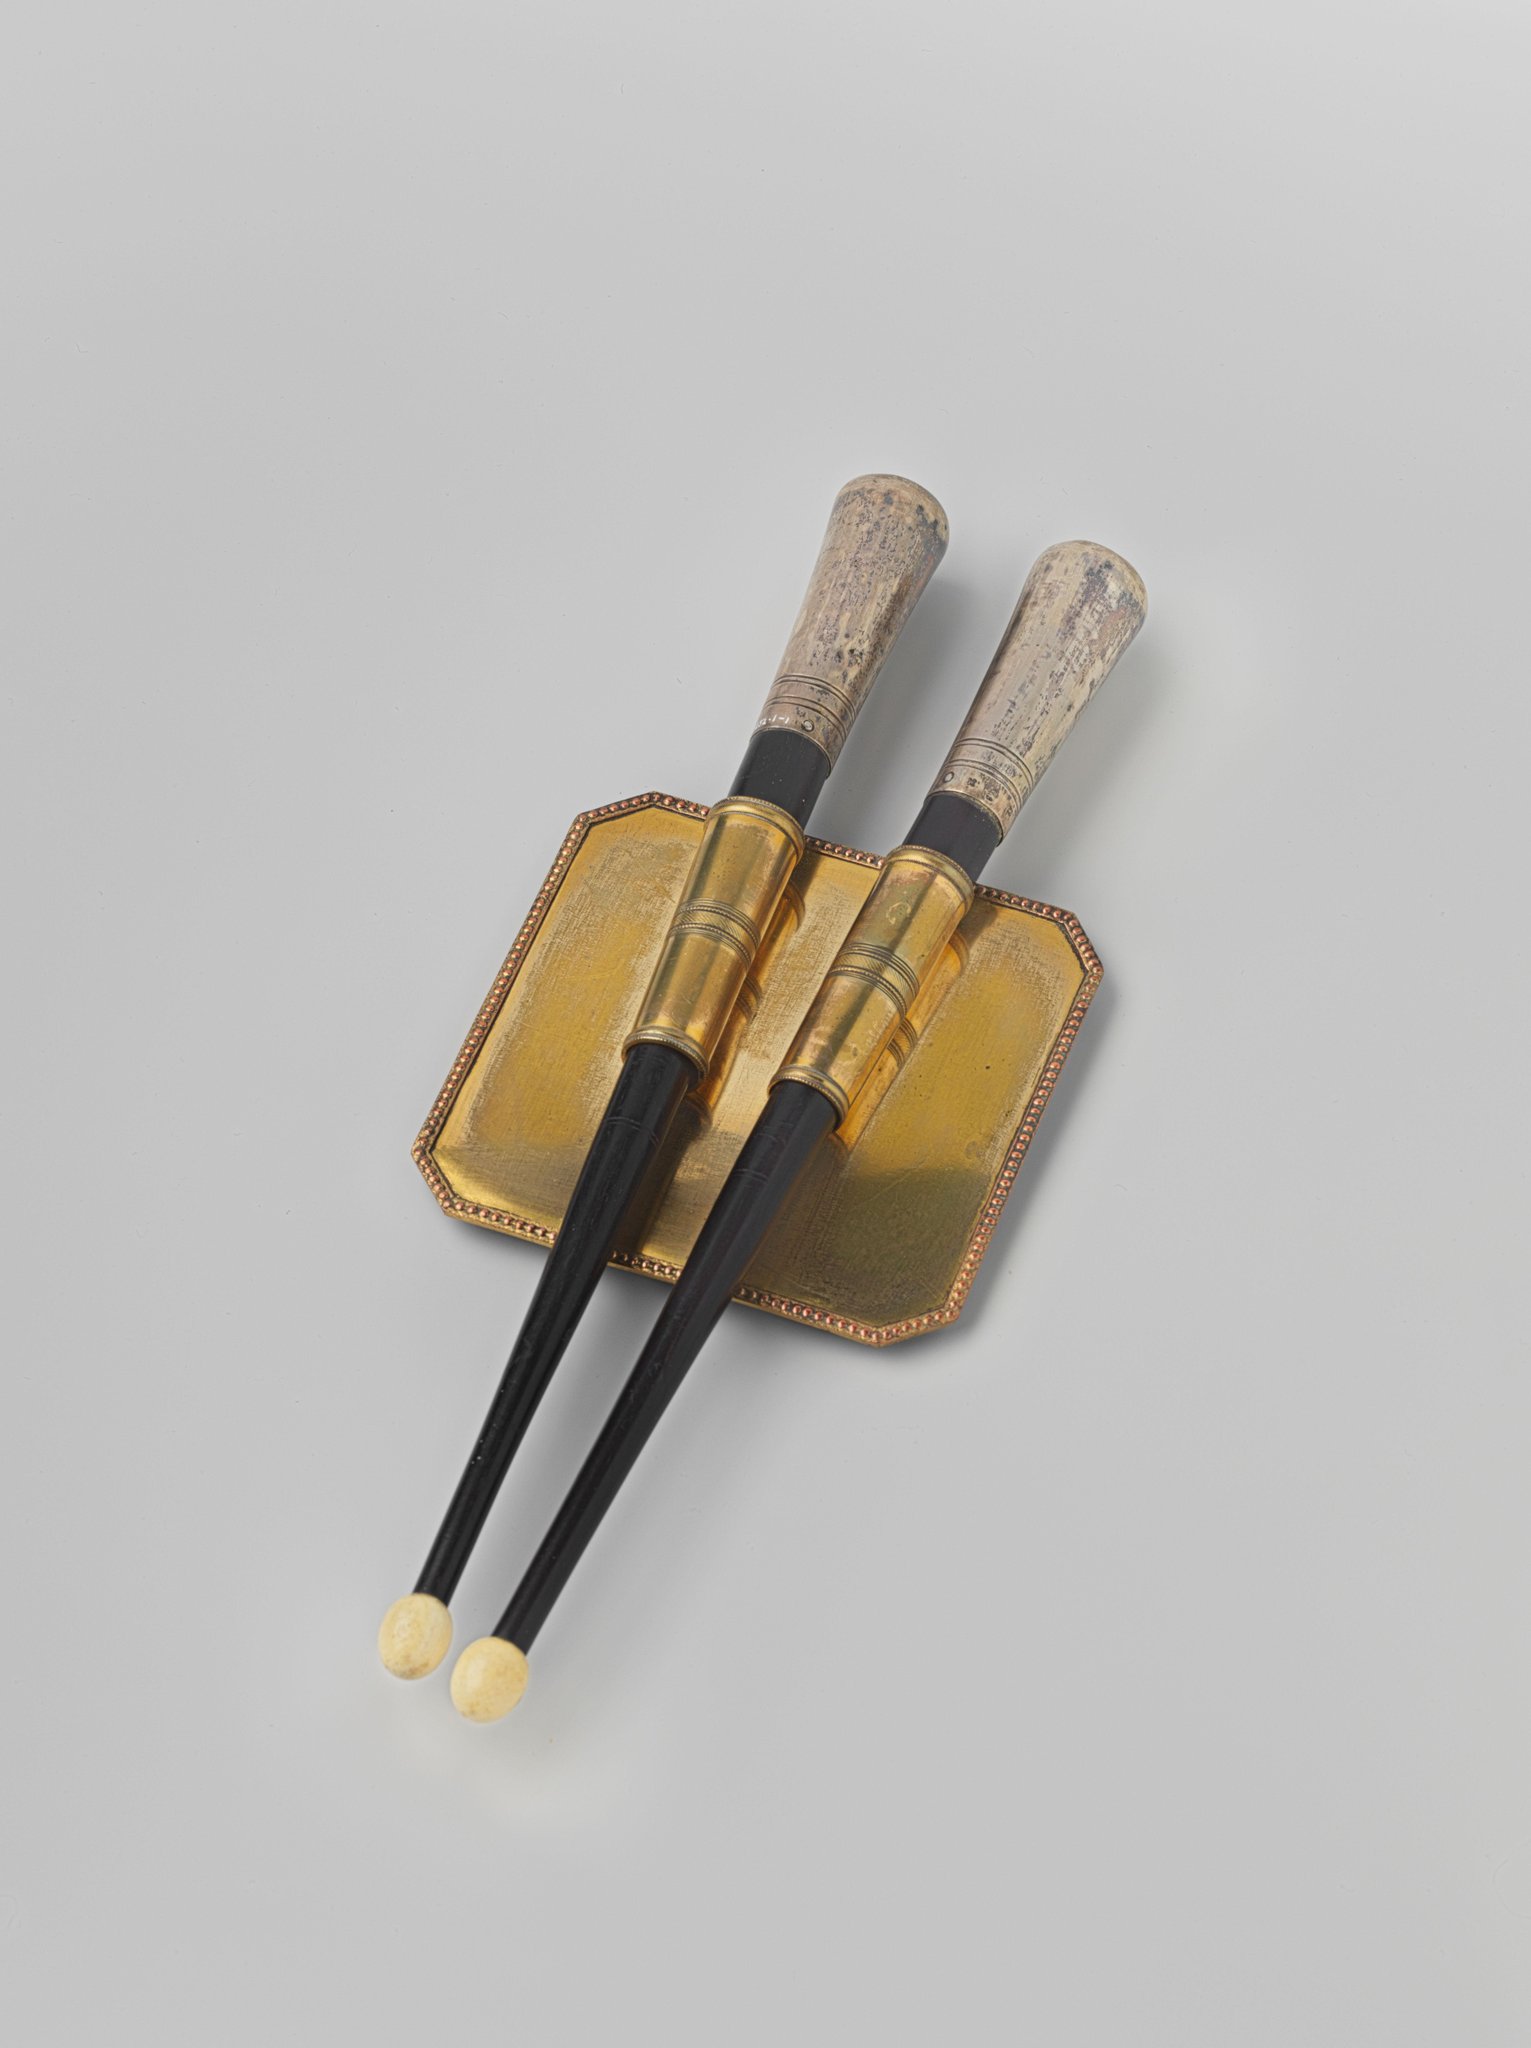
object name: element of musical instrument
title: Drumsticks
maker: Anonymous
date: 1817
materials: wood, ivory, silver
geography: netherlands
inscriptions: date letter, maker's mark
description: Ebbenhouten tromstok met ivoren knop. De stok is bezet met een zilveren bus.